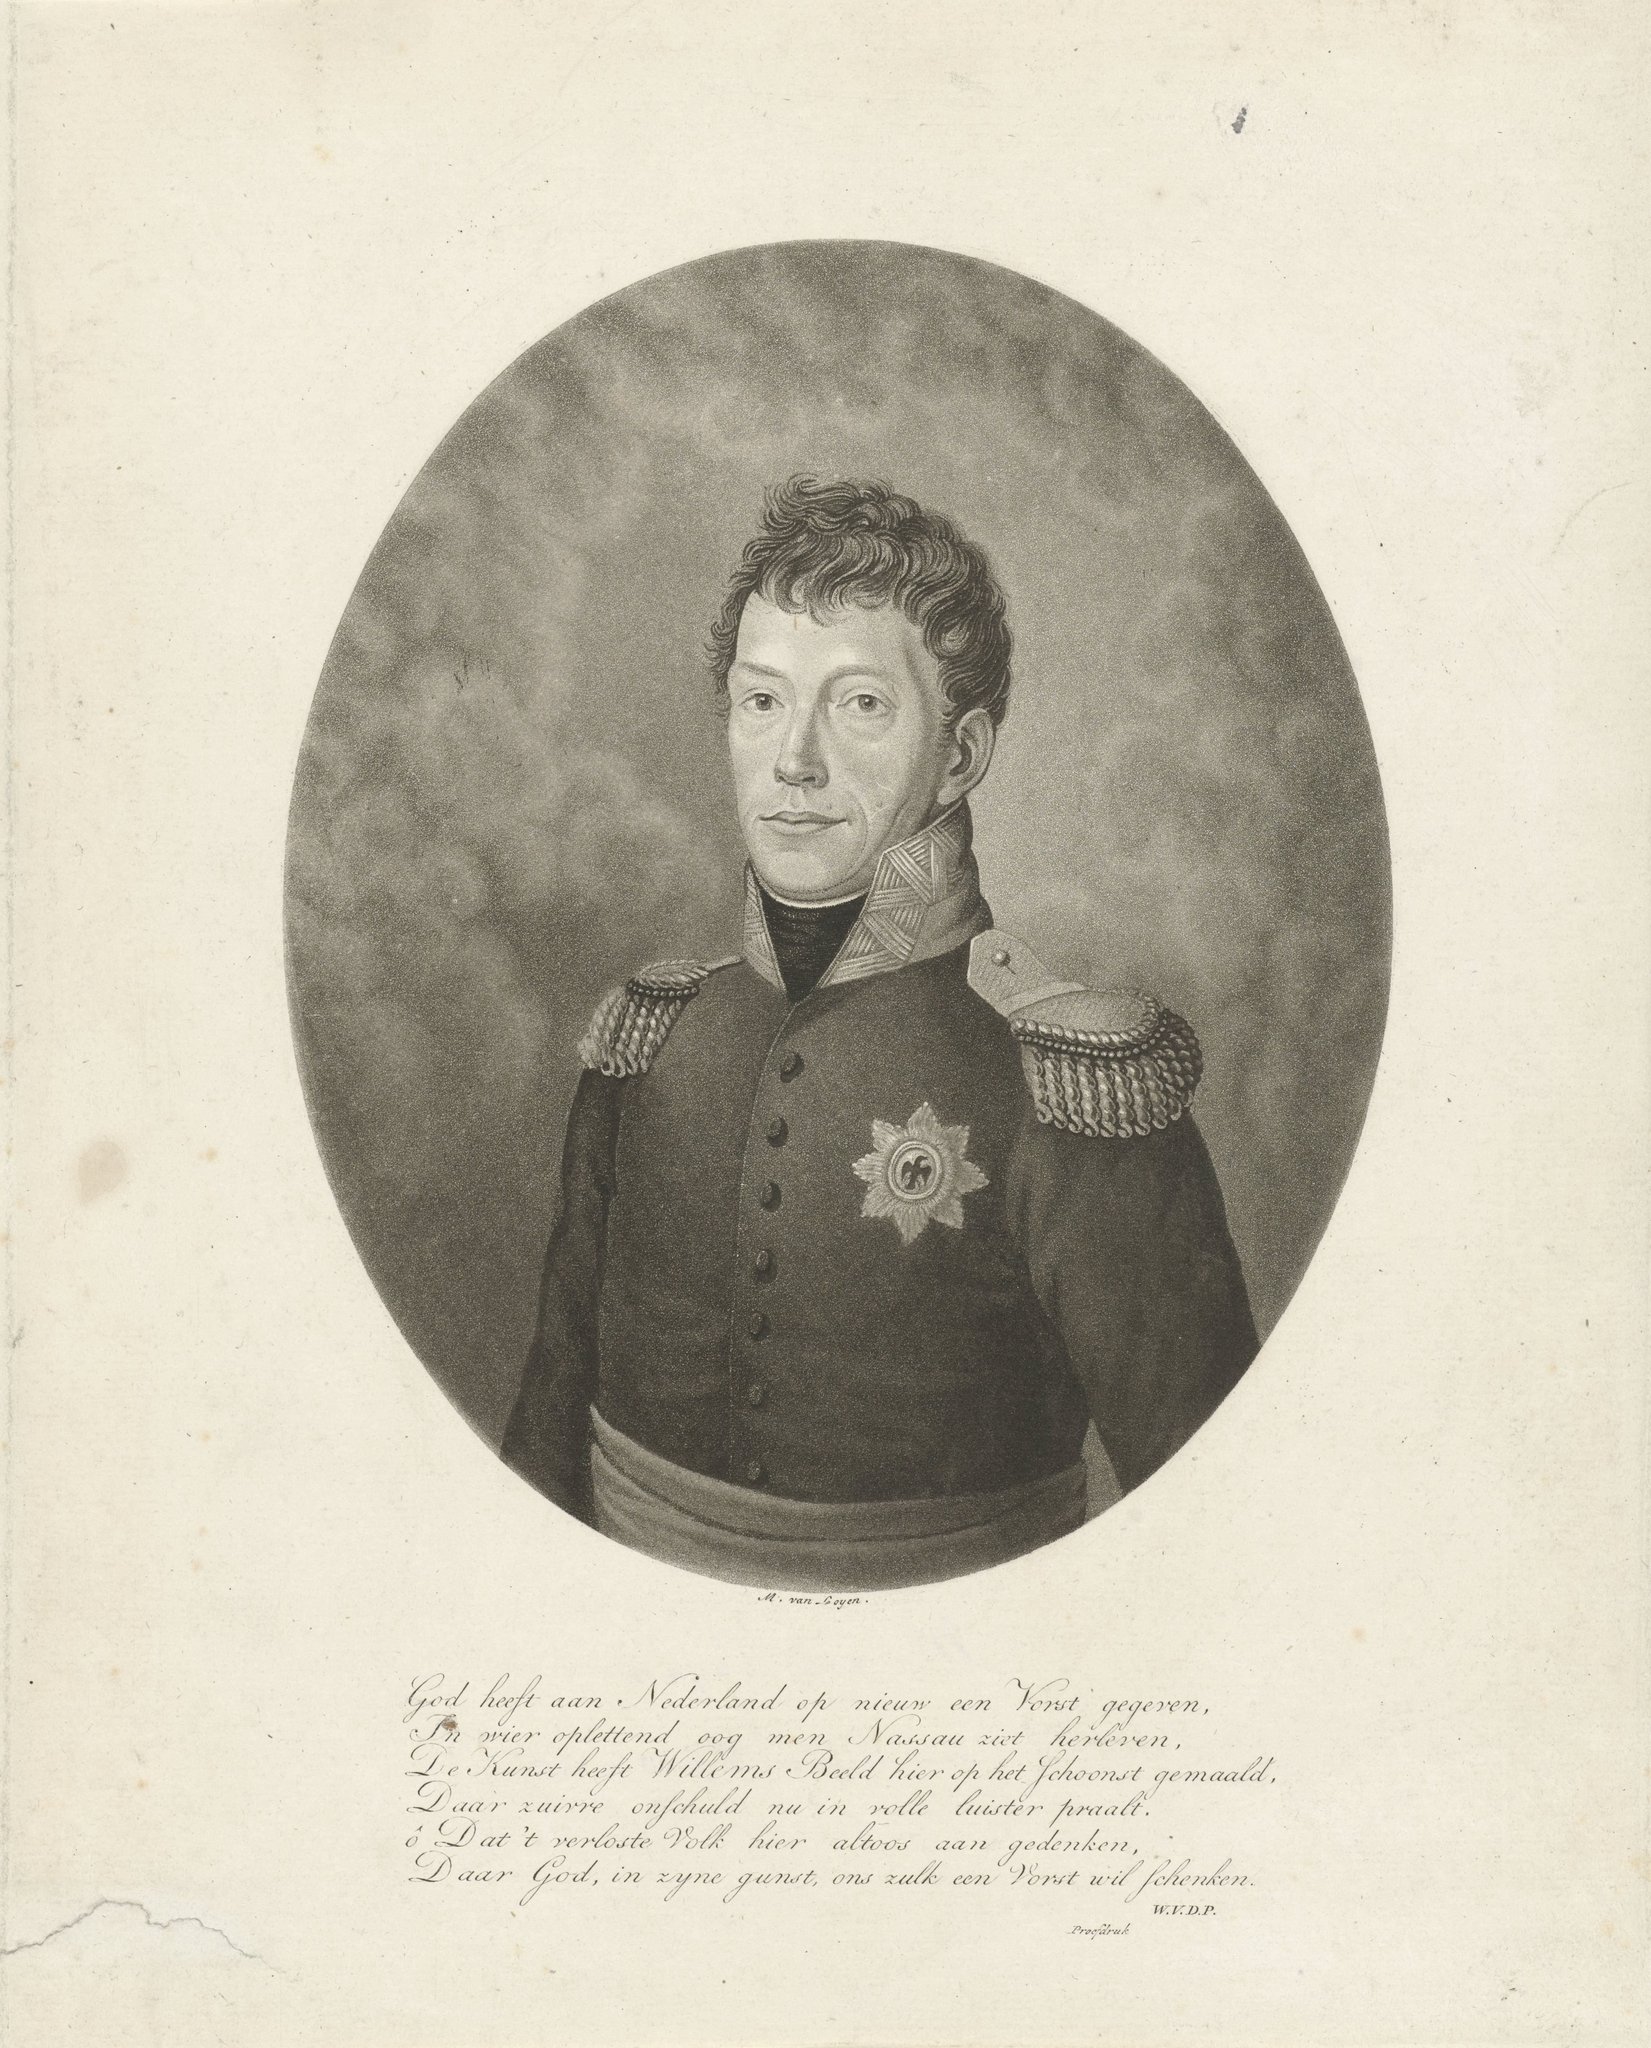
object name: print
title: Portret van koning Willem I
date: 1806-1814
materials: paper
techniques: aquatint, etching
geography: amsterdam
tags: william i of the netherlands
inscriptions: collector's mark: Lugt 2228, collector's mark: Lugt 2760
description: Portret van Willem I Frederik, koning der Nederlanden.